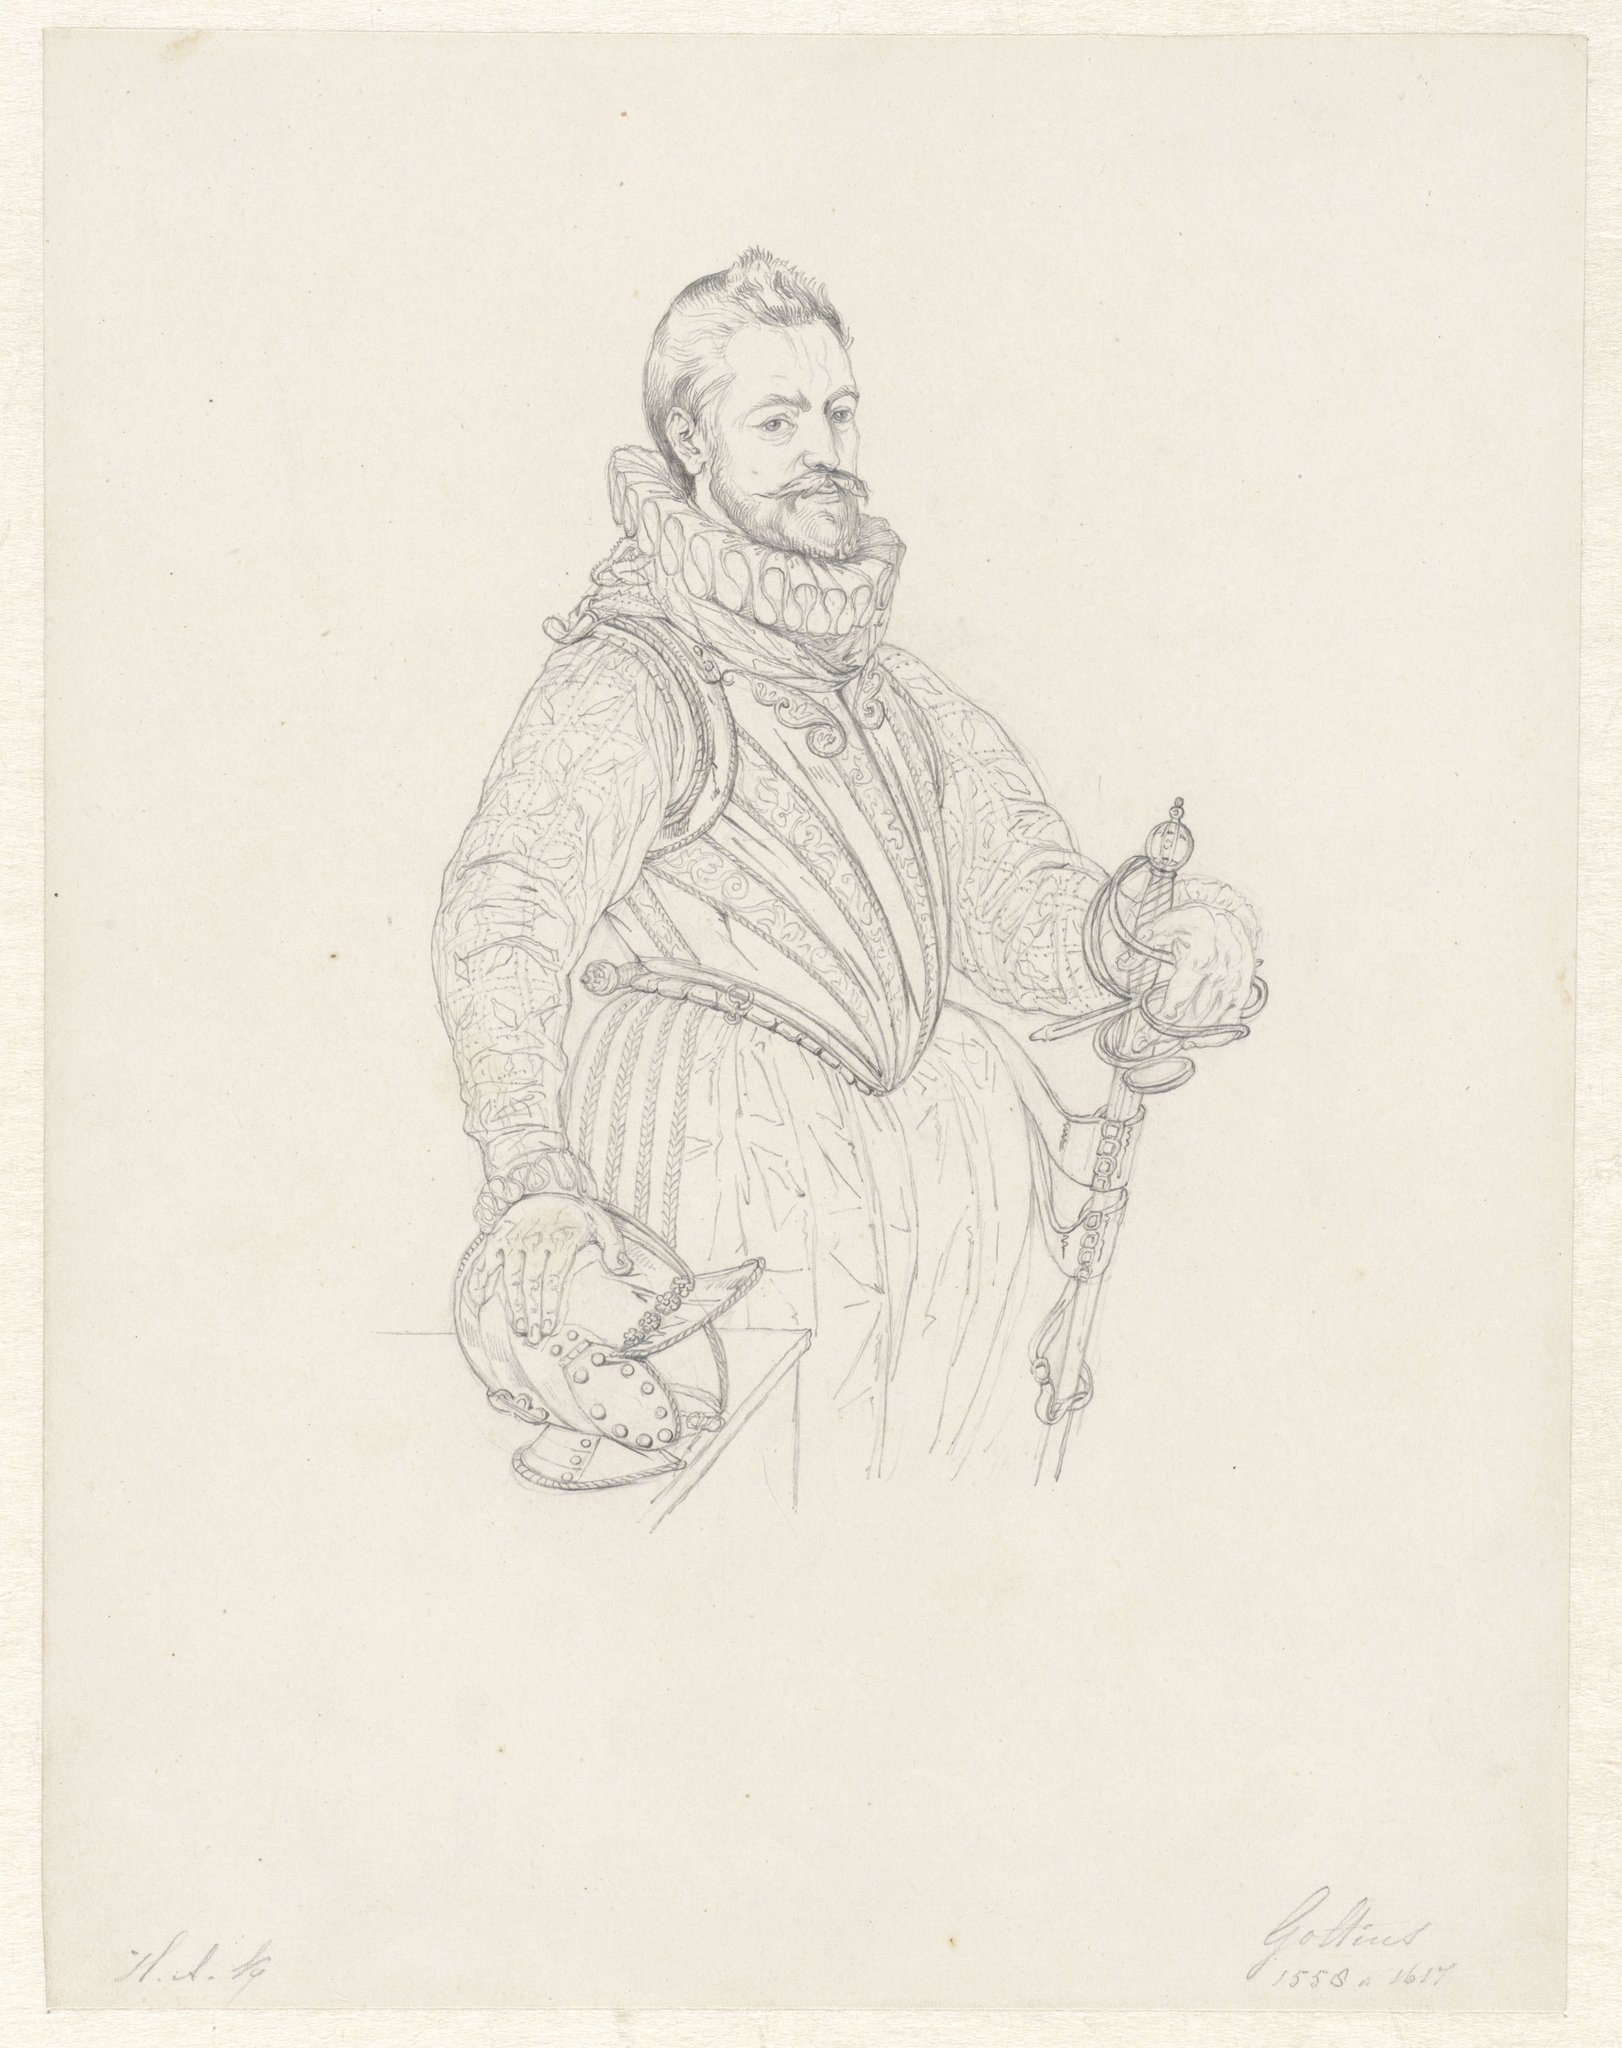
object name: drawing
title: Portret van Jacques de la Faille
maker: hendrik abraham klinkhamer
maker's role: draughtsman, painter, print maker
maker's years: 1810-1872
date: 1820-1872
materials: paper, pencil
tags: historical persons